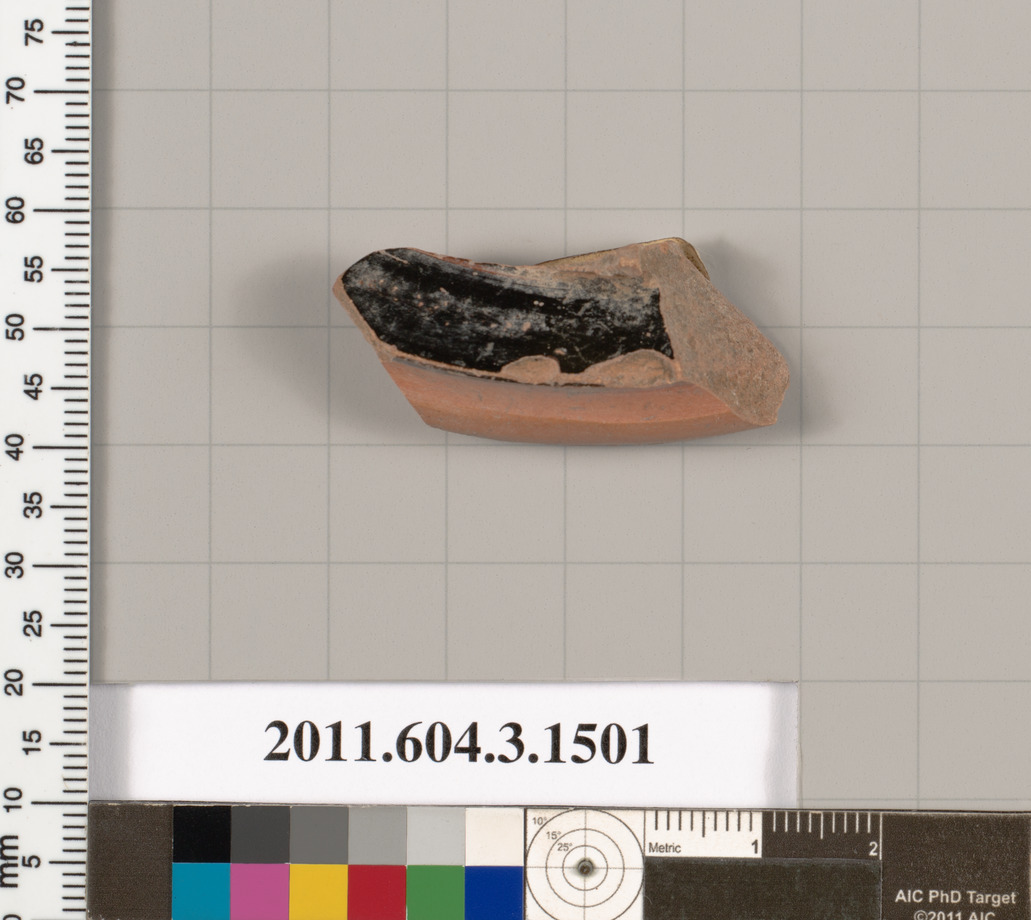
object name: skyphos fragment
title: Terracotta fragment of a skyphos (deep drinking cup)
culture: greek, attic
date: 600-401 BCE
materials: terracotta